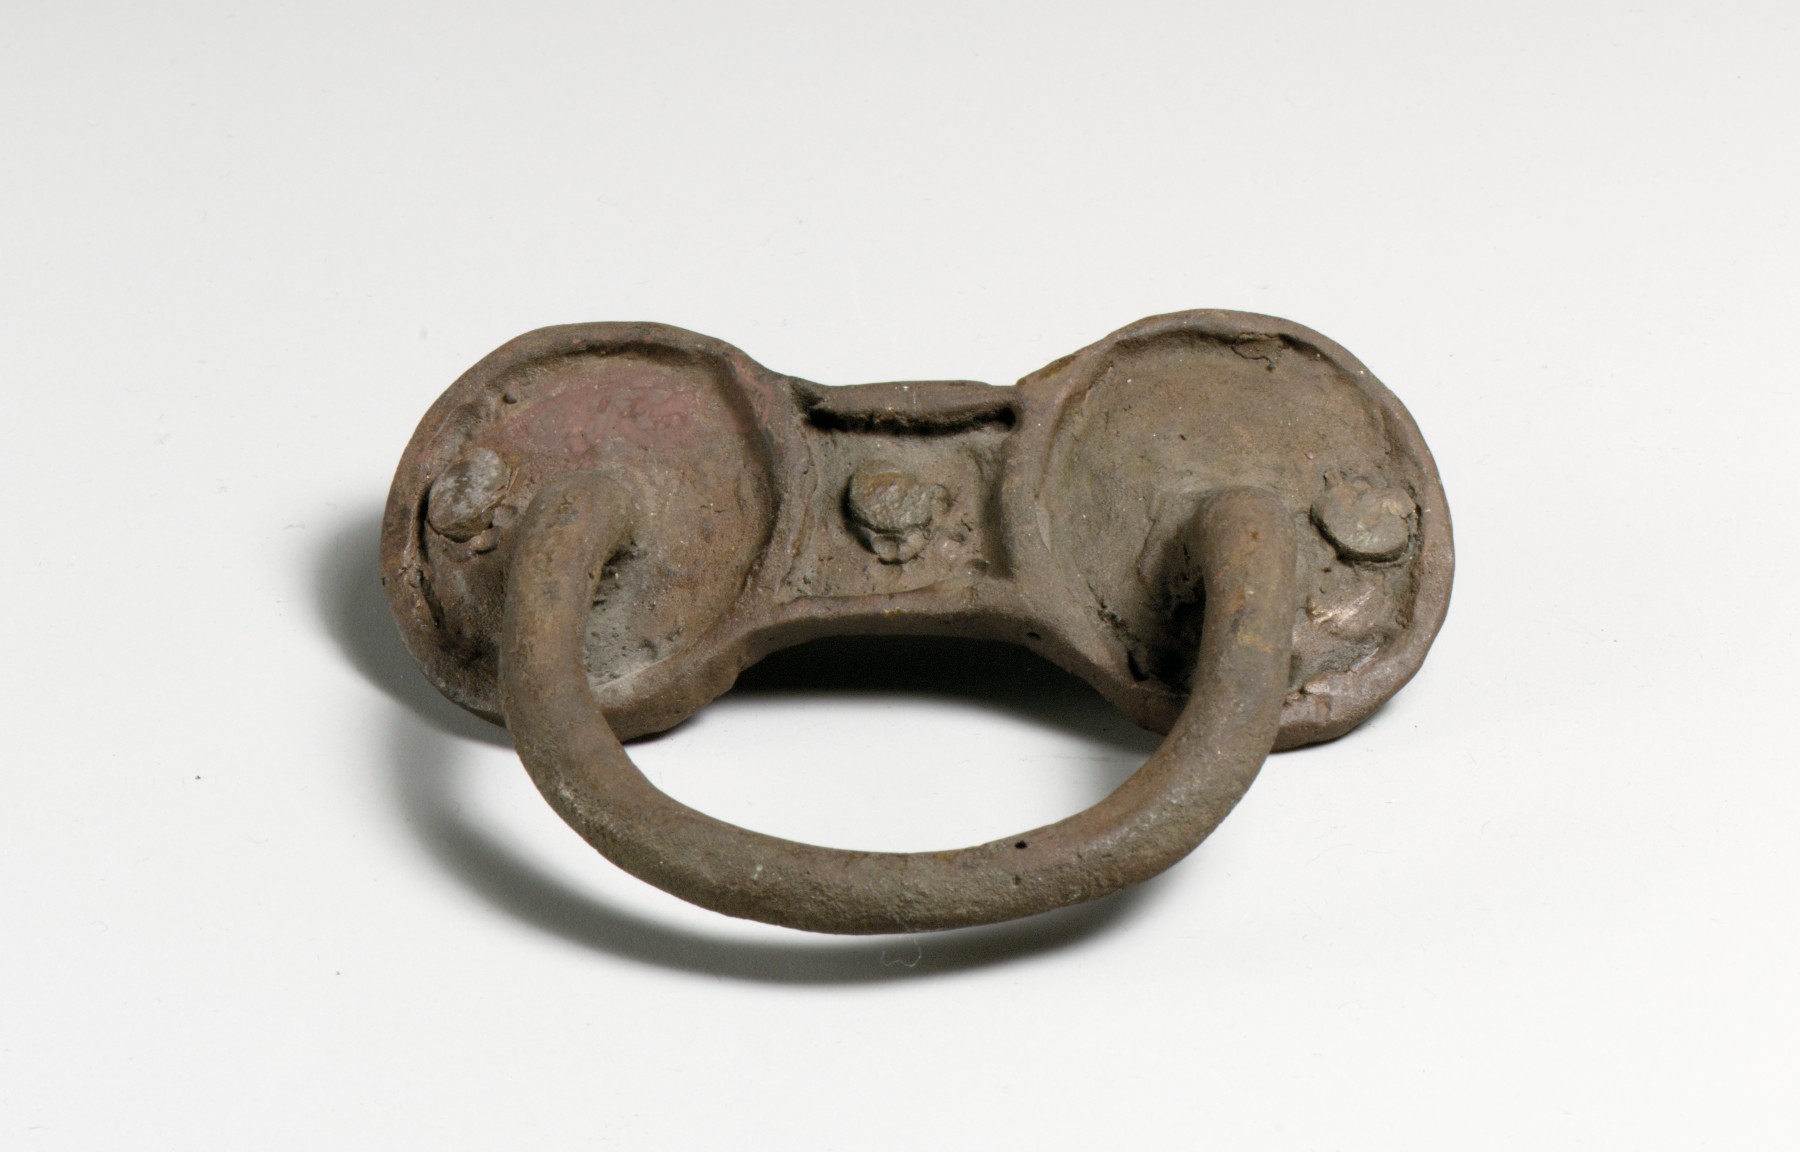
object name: handle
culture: cypriot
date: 700-501 BCE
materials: bronze